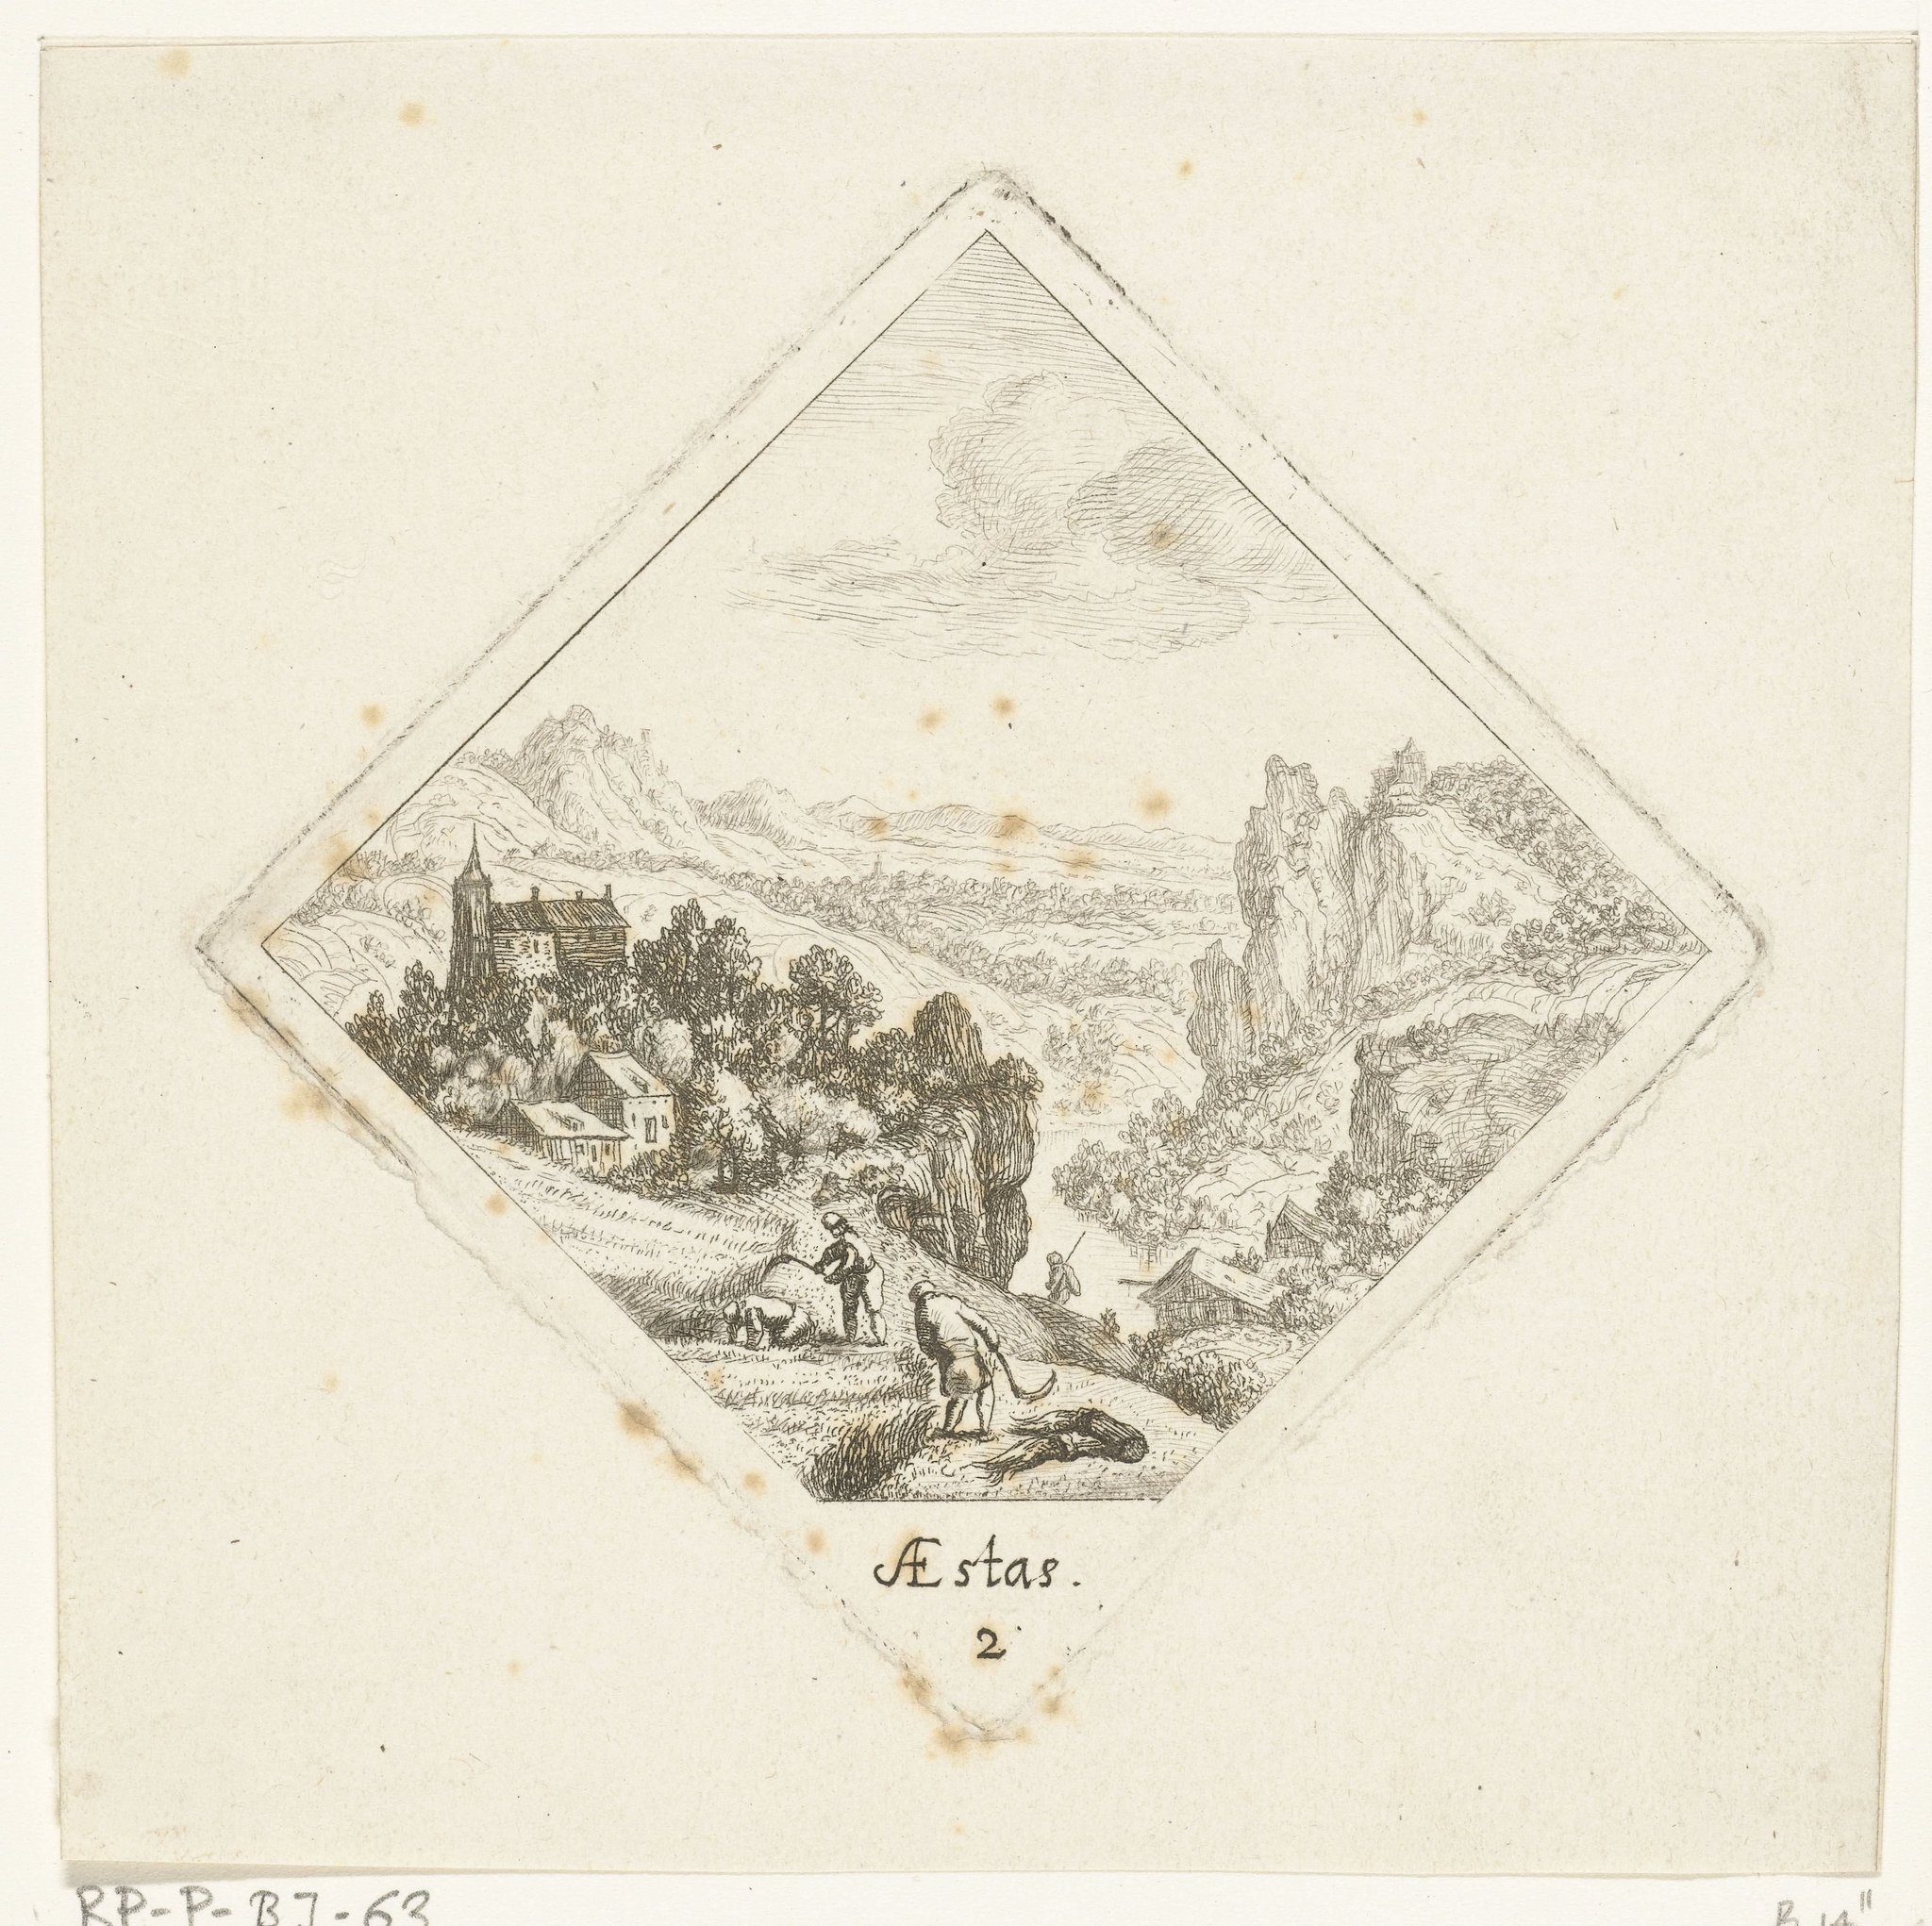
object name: print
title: De vier jaargetijden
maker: jan van almeloveen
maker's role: draughtsman, print maker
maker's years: 1652-1683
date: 1662-1683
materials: paper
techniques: etching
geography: netherlands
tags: summer ~ human activities (the four seasons of the year), spring landscape; landscape symbolizing spring (the four seasons of the year)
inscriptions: collector's mark: Lugt 2228, collector's mark: Lugt 2165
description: Twee mannen oogsten graan, op de achtergrond een berglandschap met links een dorp.